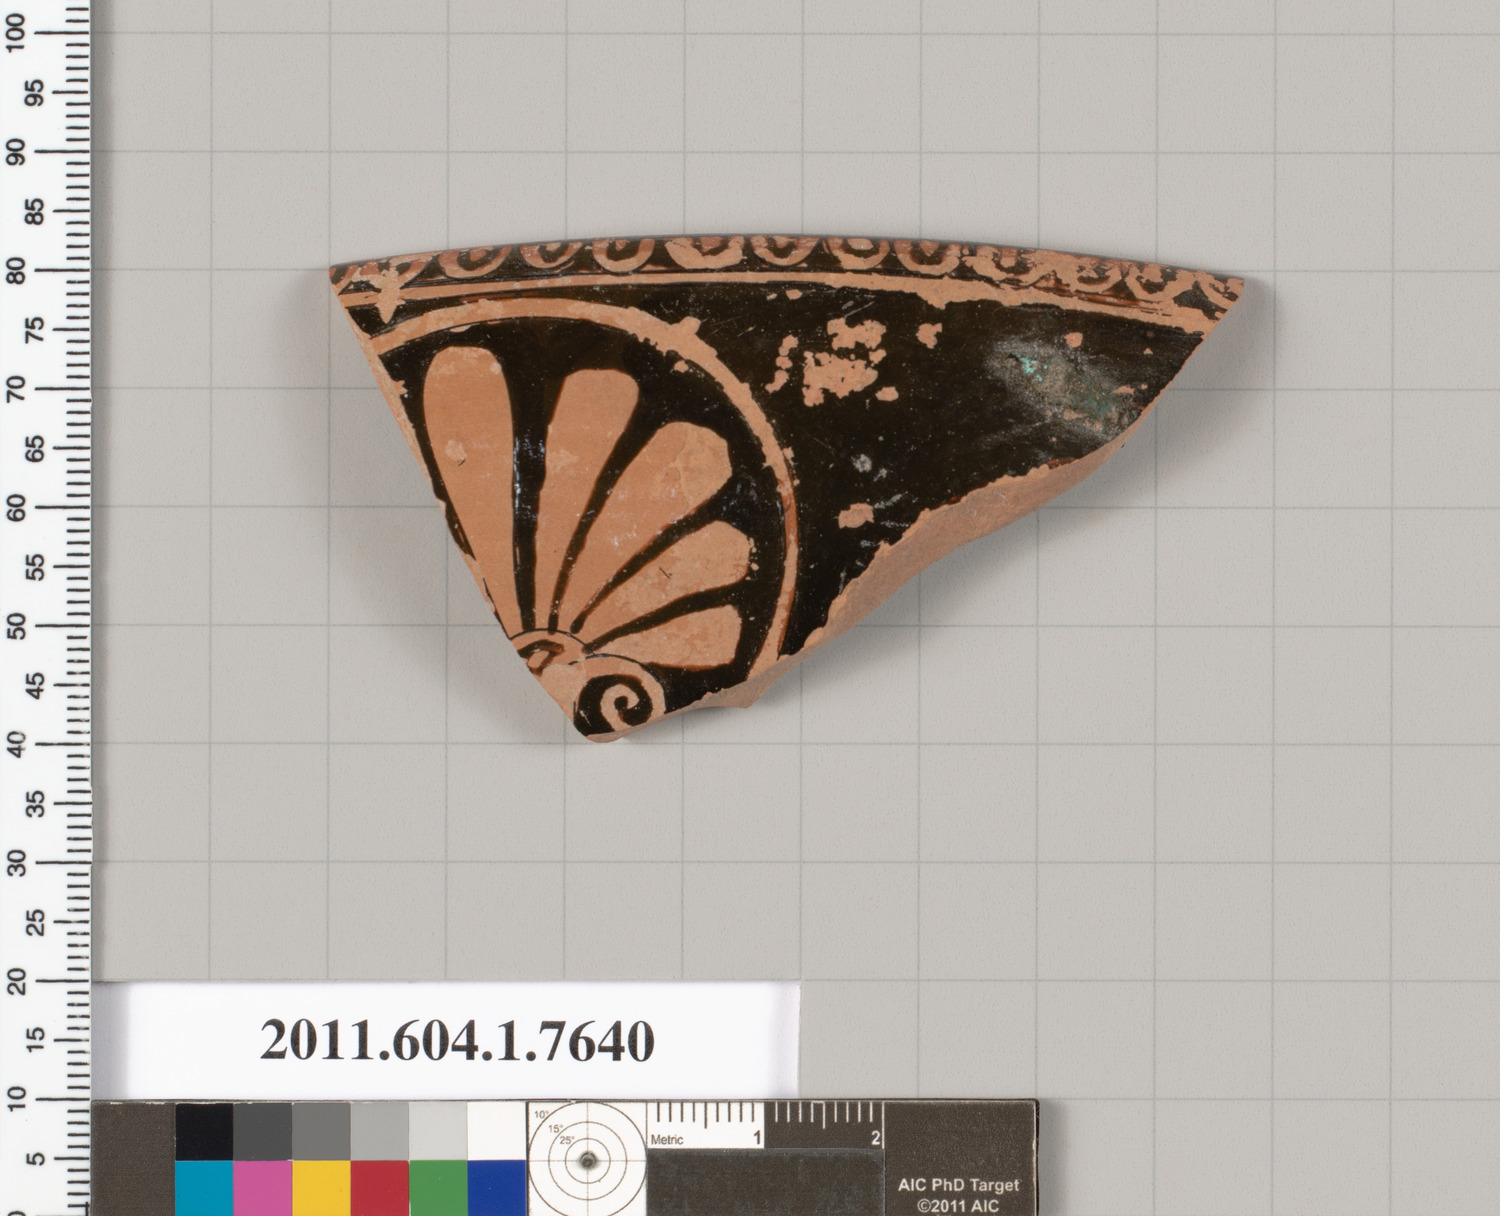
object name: kylix fragment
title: Terracotta fragment of a kylix (drinking cup)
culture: greek, attic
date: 460-450 BCE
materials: terracotta